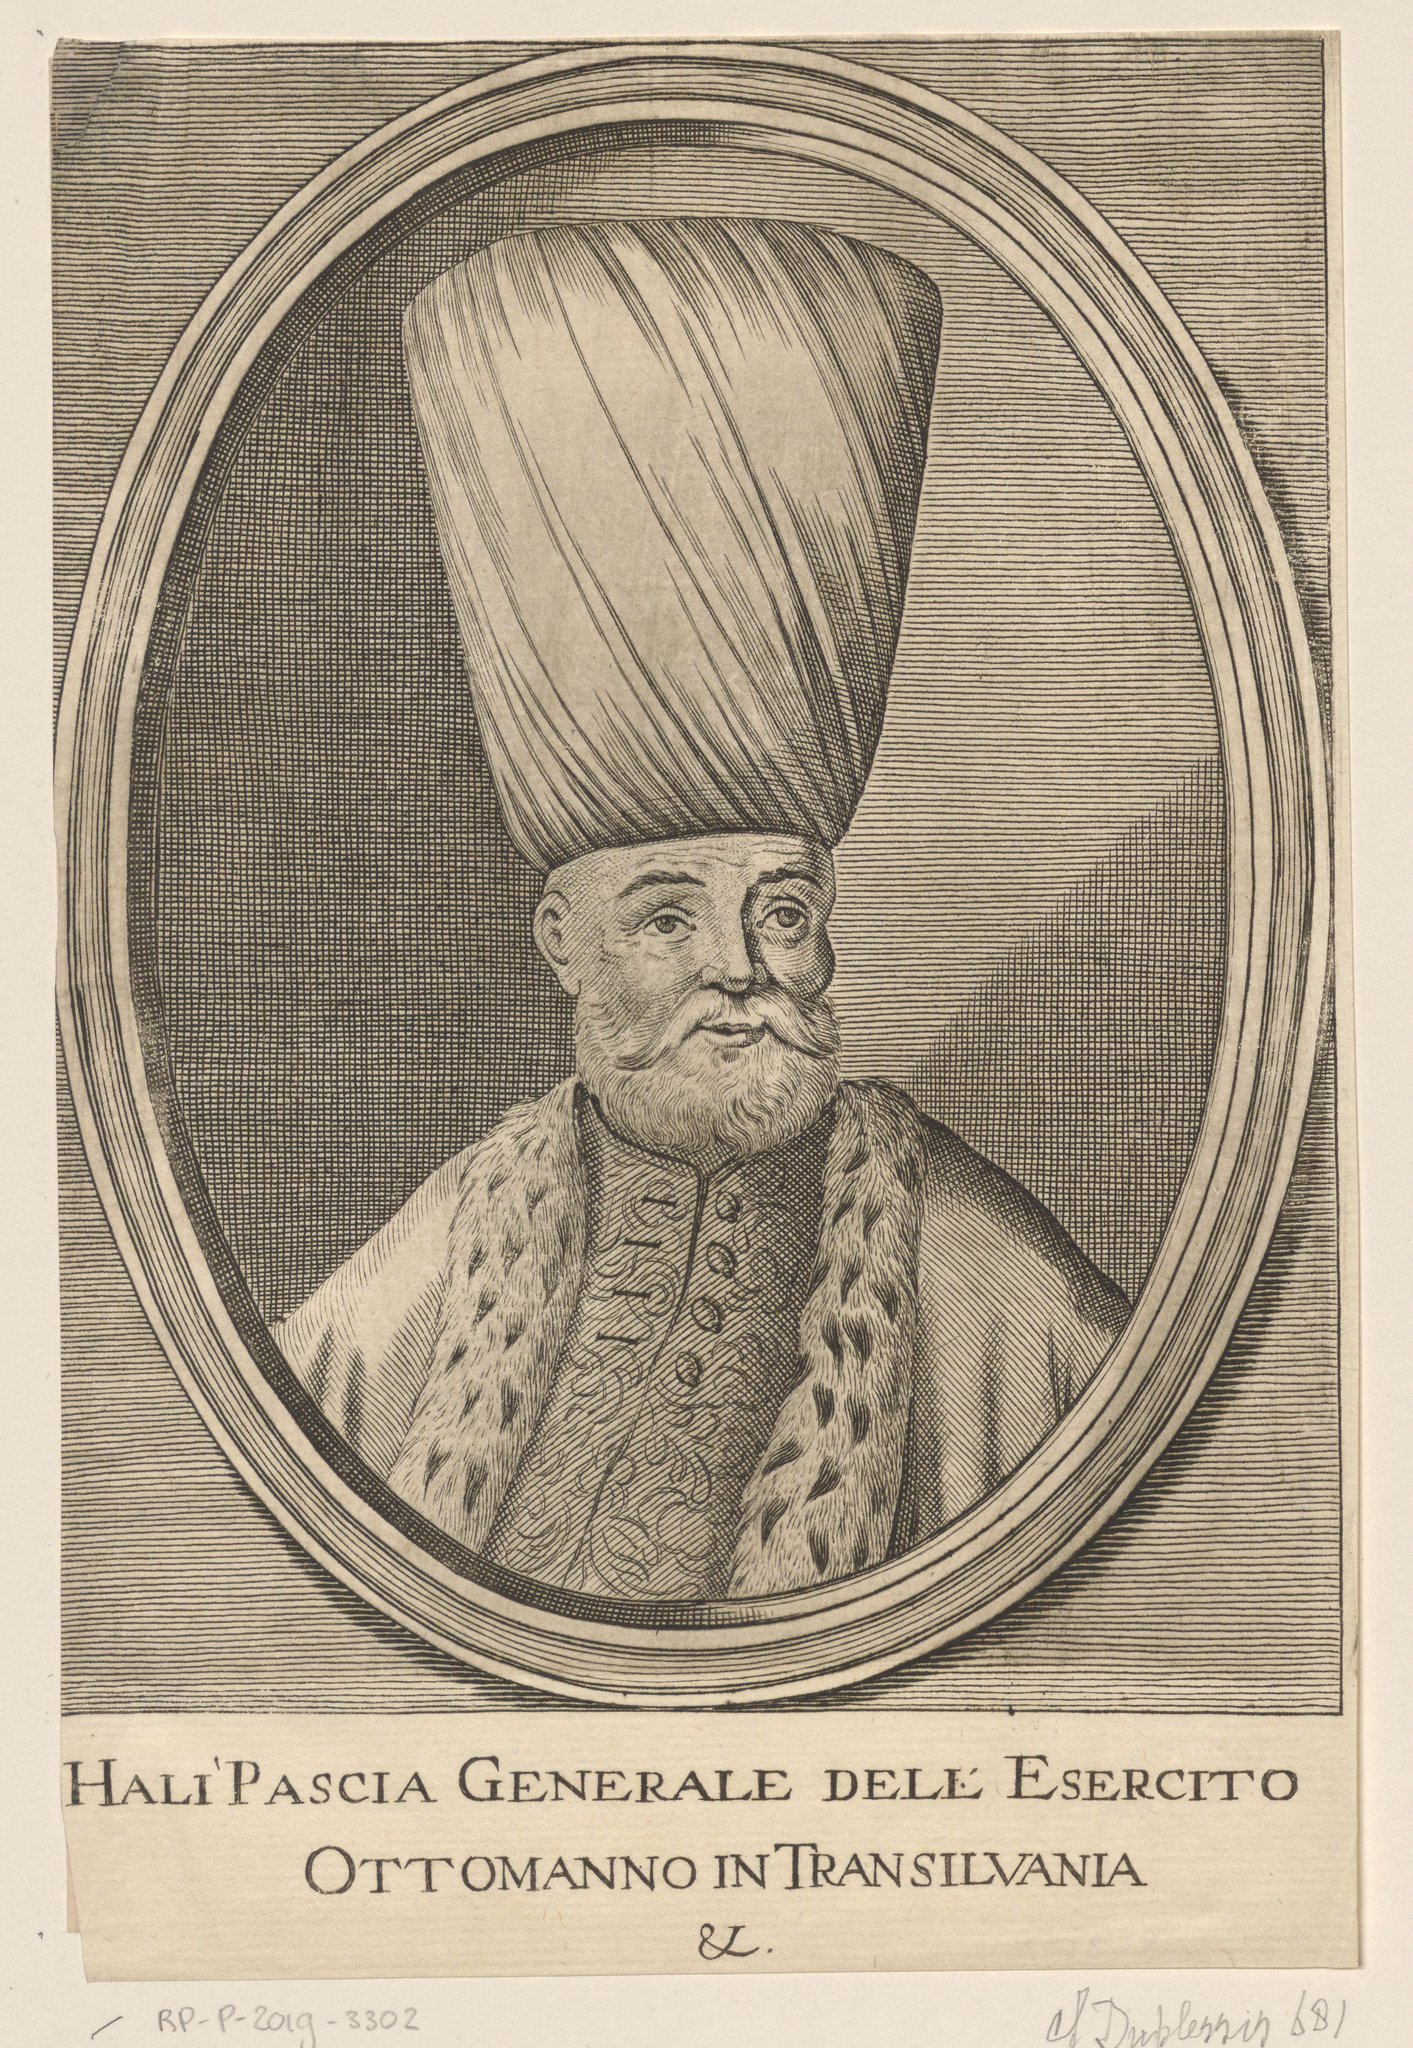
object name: print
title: Portret van Ali-Bassa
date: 1670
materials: paper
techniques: engraving, etching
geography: vienna state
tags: asiatic races and peoples: turks, historical persons, head-gear: turban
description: Prent uit: Historia di Leopoldo Cesare. Wenen: Giovanni Battista Hacque, 1670.